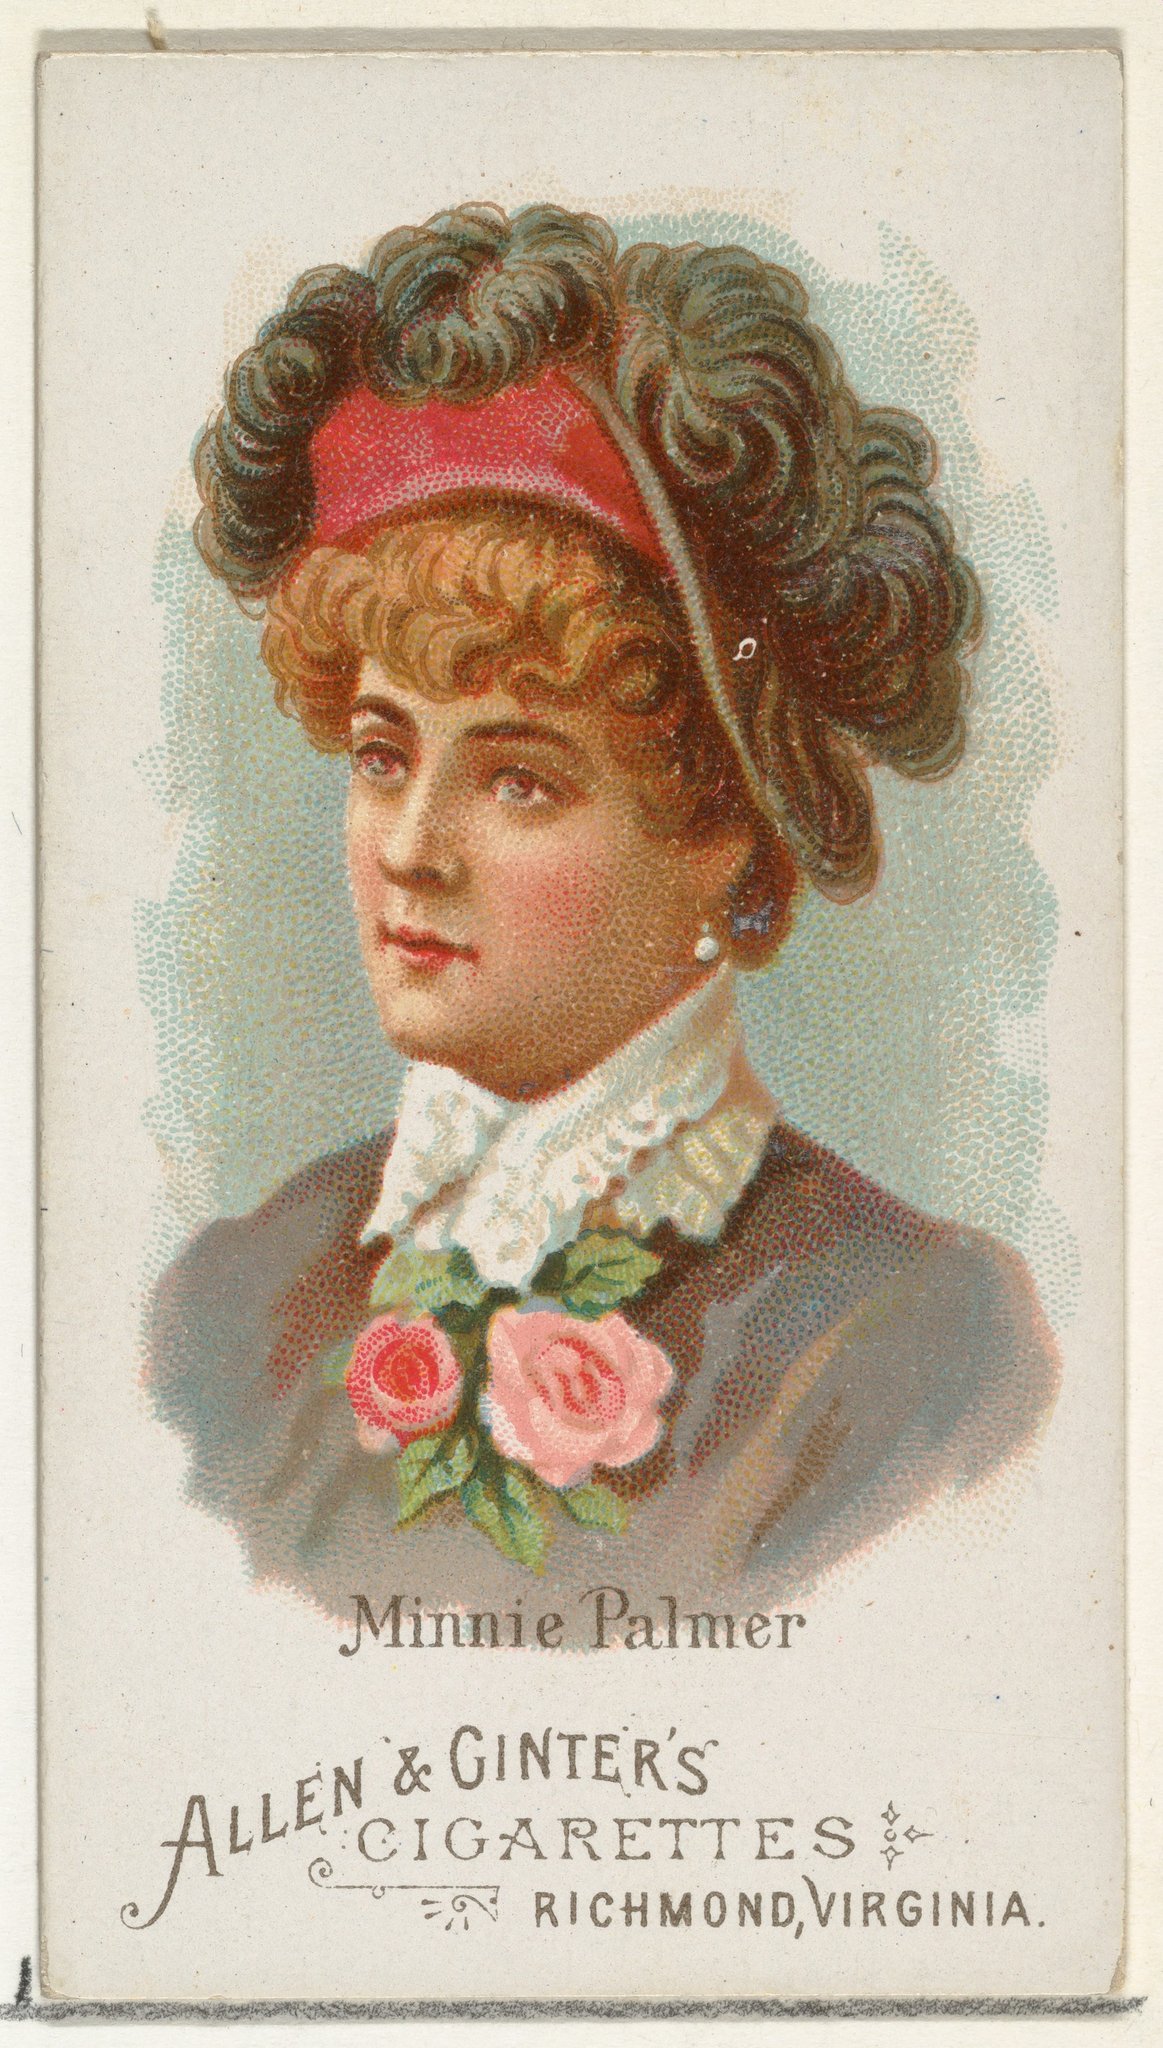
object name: print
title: Minnie Palmer, from World's Beauties, Series 1 (N26) for Allen & Ginter Cigarettes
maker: allen & ginter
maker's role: publisher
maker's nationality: american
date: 1888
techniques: color lithograph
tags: women